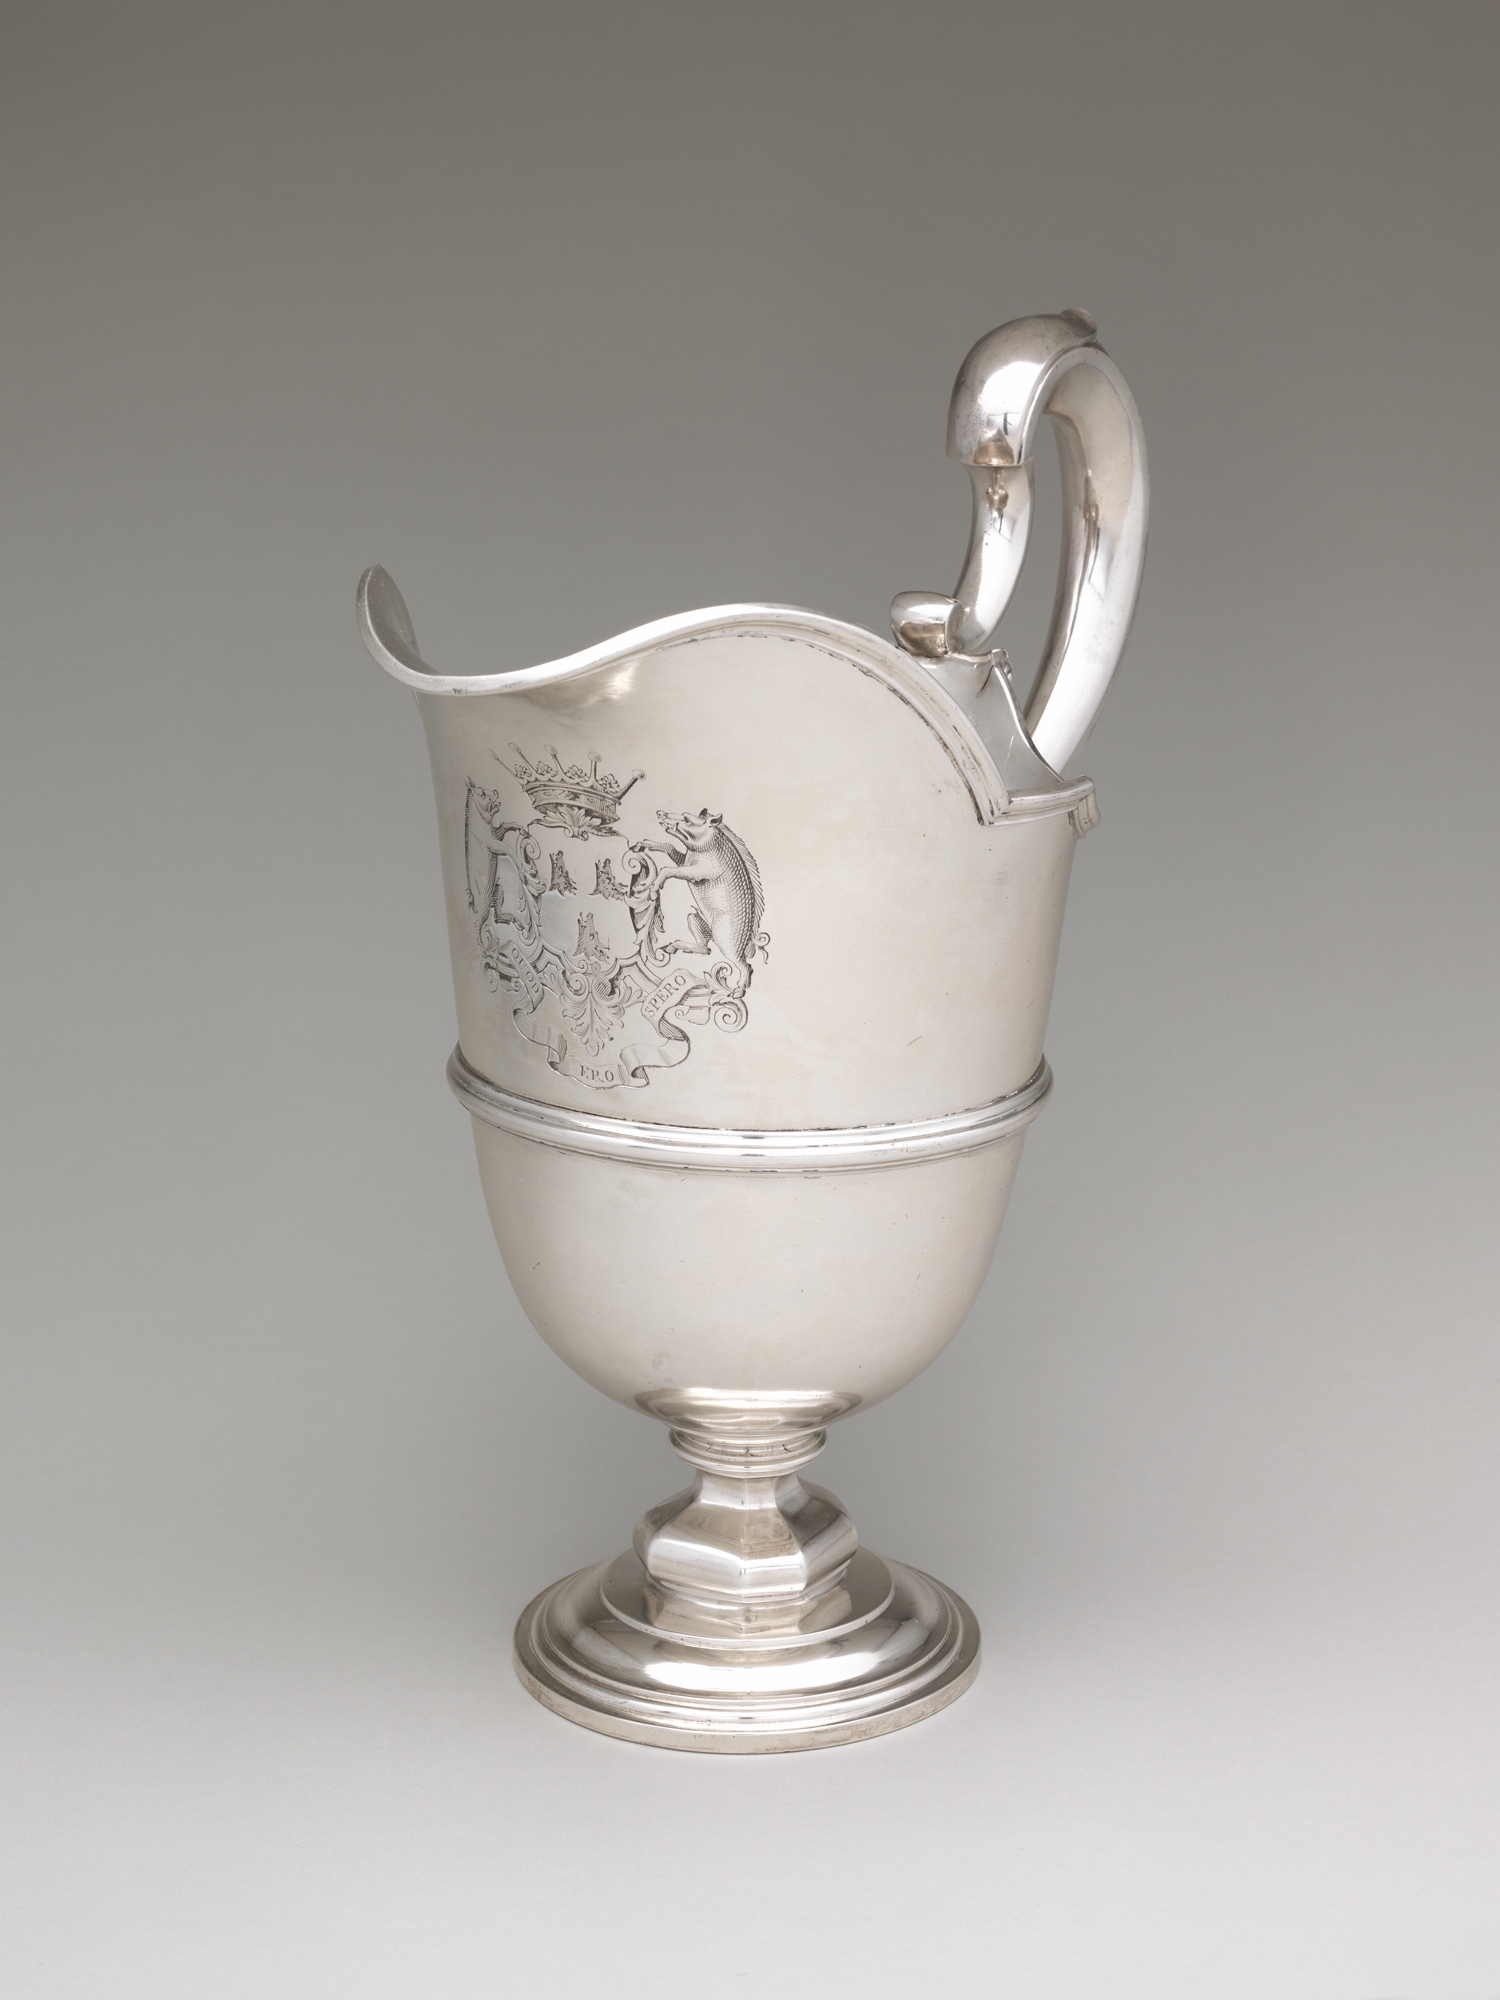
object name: ewer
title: Ewer (one of a pair)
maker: peter archambo i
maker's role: maker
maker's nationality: british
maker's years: 1659-1759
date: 1740-1741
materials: silver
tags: animals,coat of arms